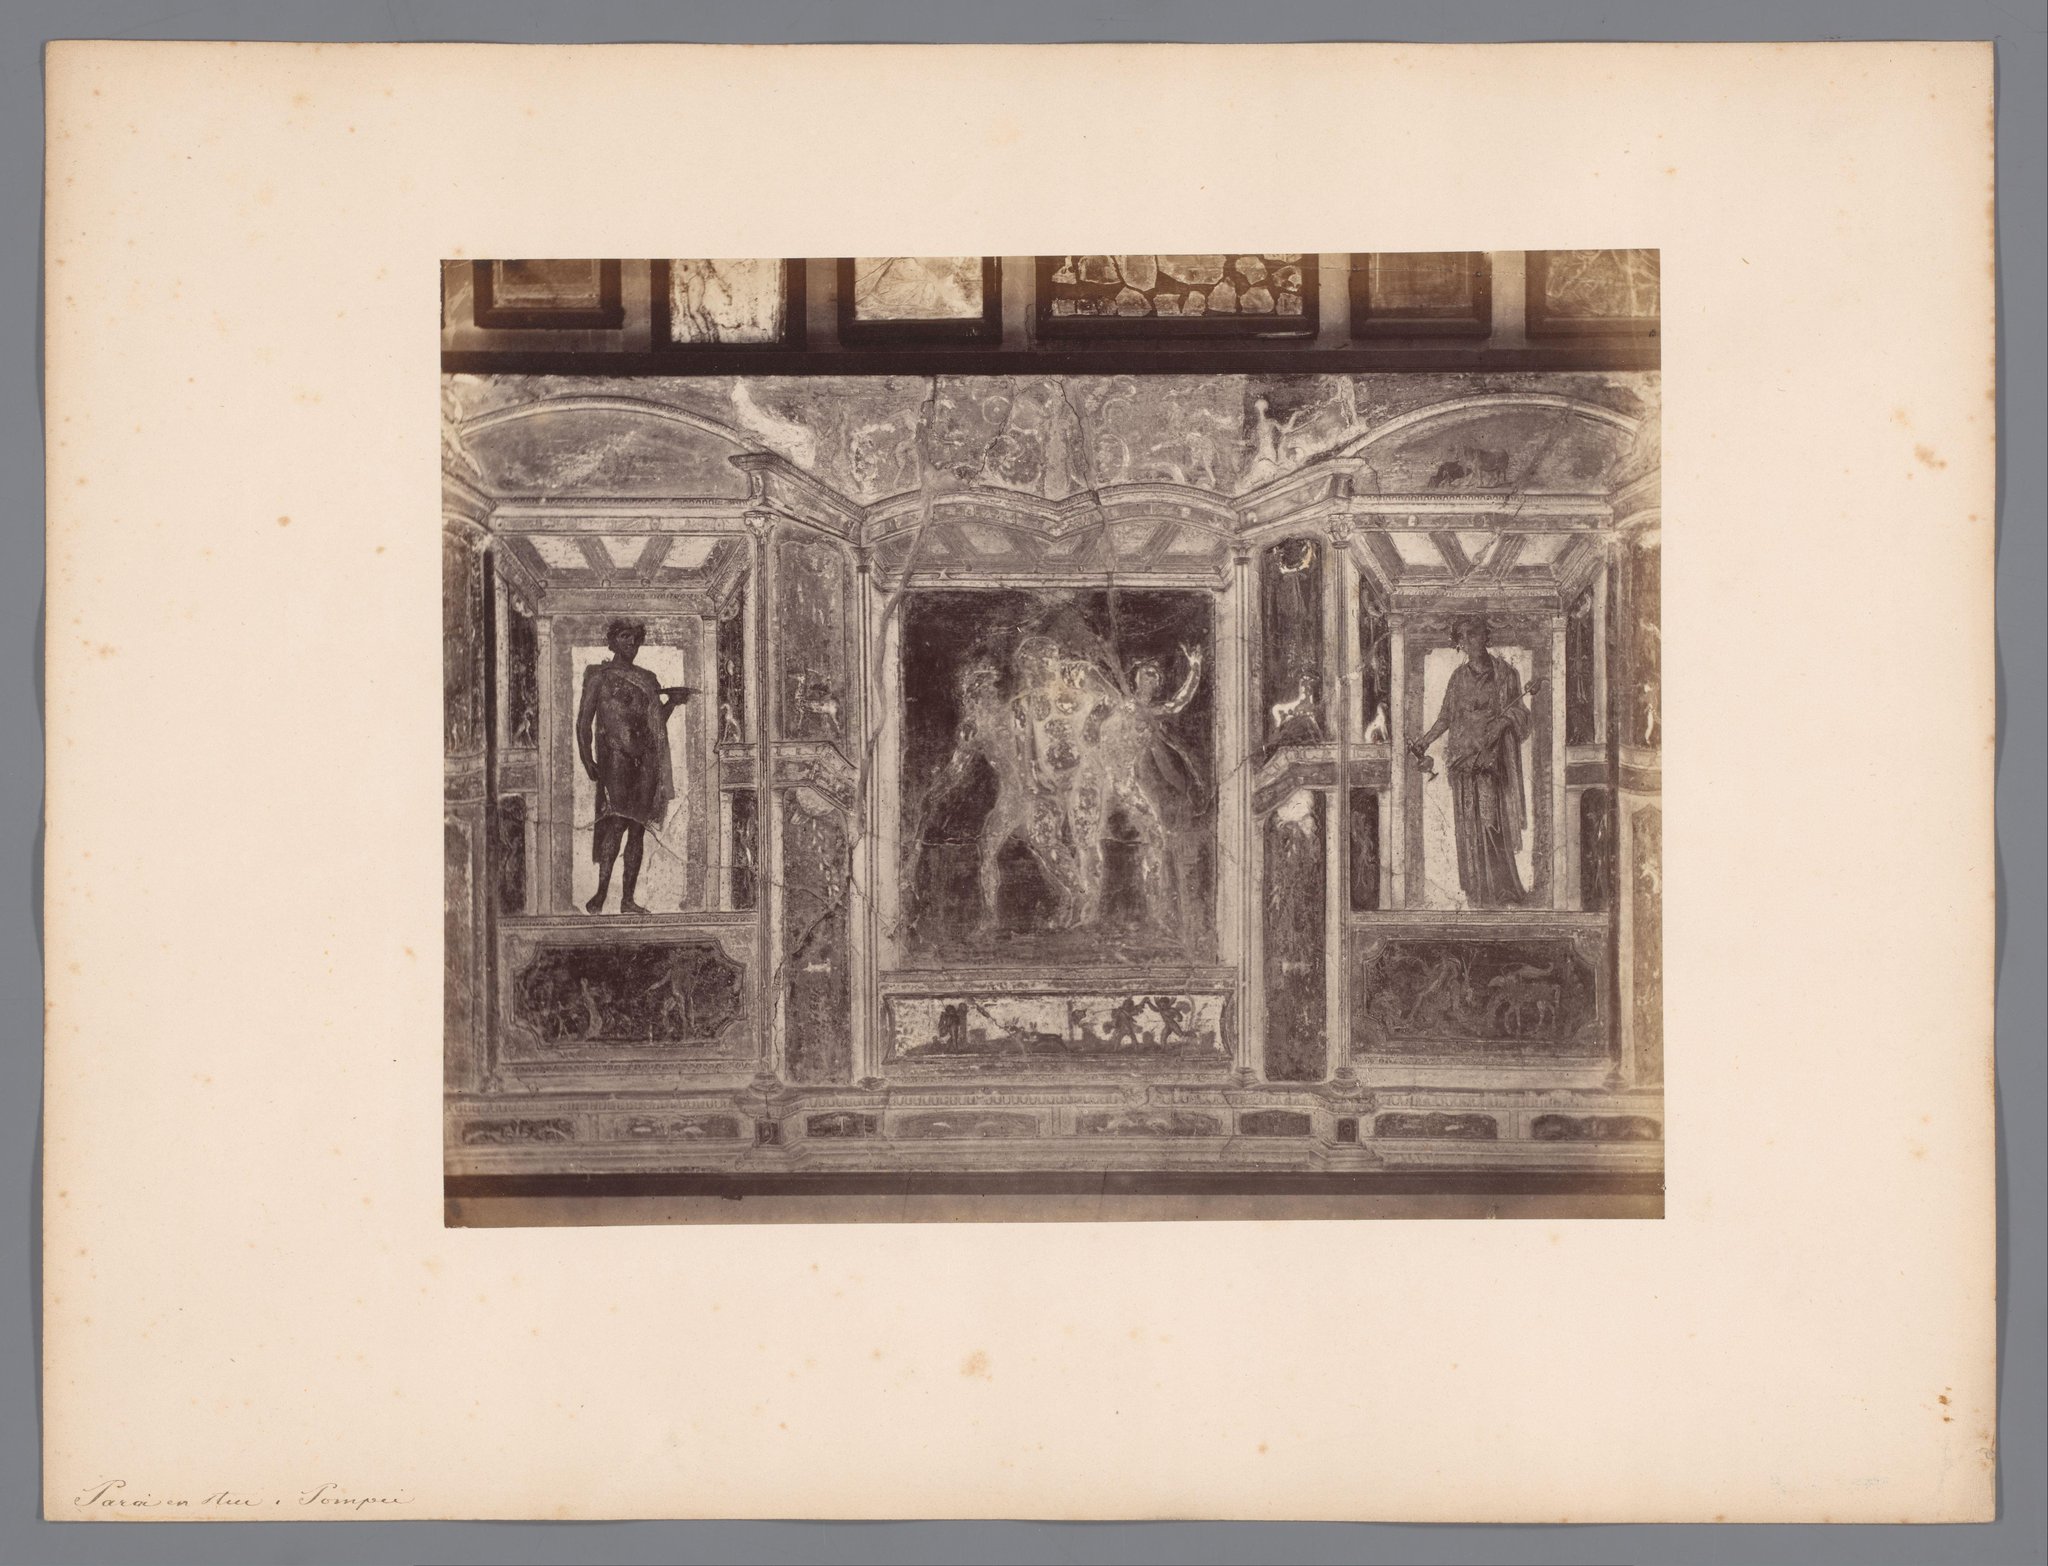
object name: photograph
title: Fotoreproductie van een fresco te Pompeï, Italië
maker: Anonymous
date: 1851-1900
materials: cardboard, paper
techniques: albumen print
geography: pompeii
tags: picture, painting, wall-covering, pompeii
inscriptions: inscription: ‘Parsi en stier, Pompei’, number: ‘75.’, number: ‘11’